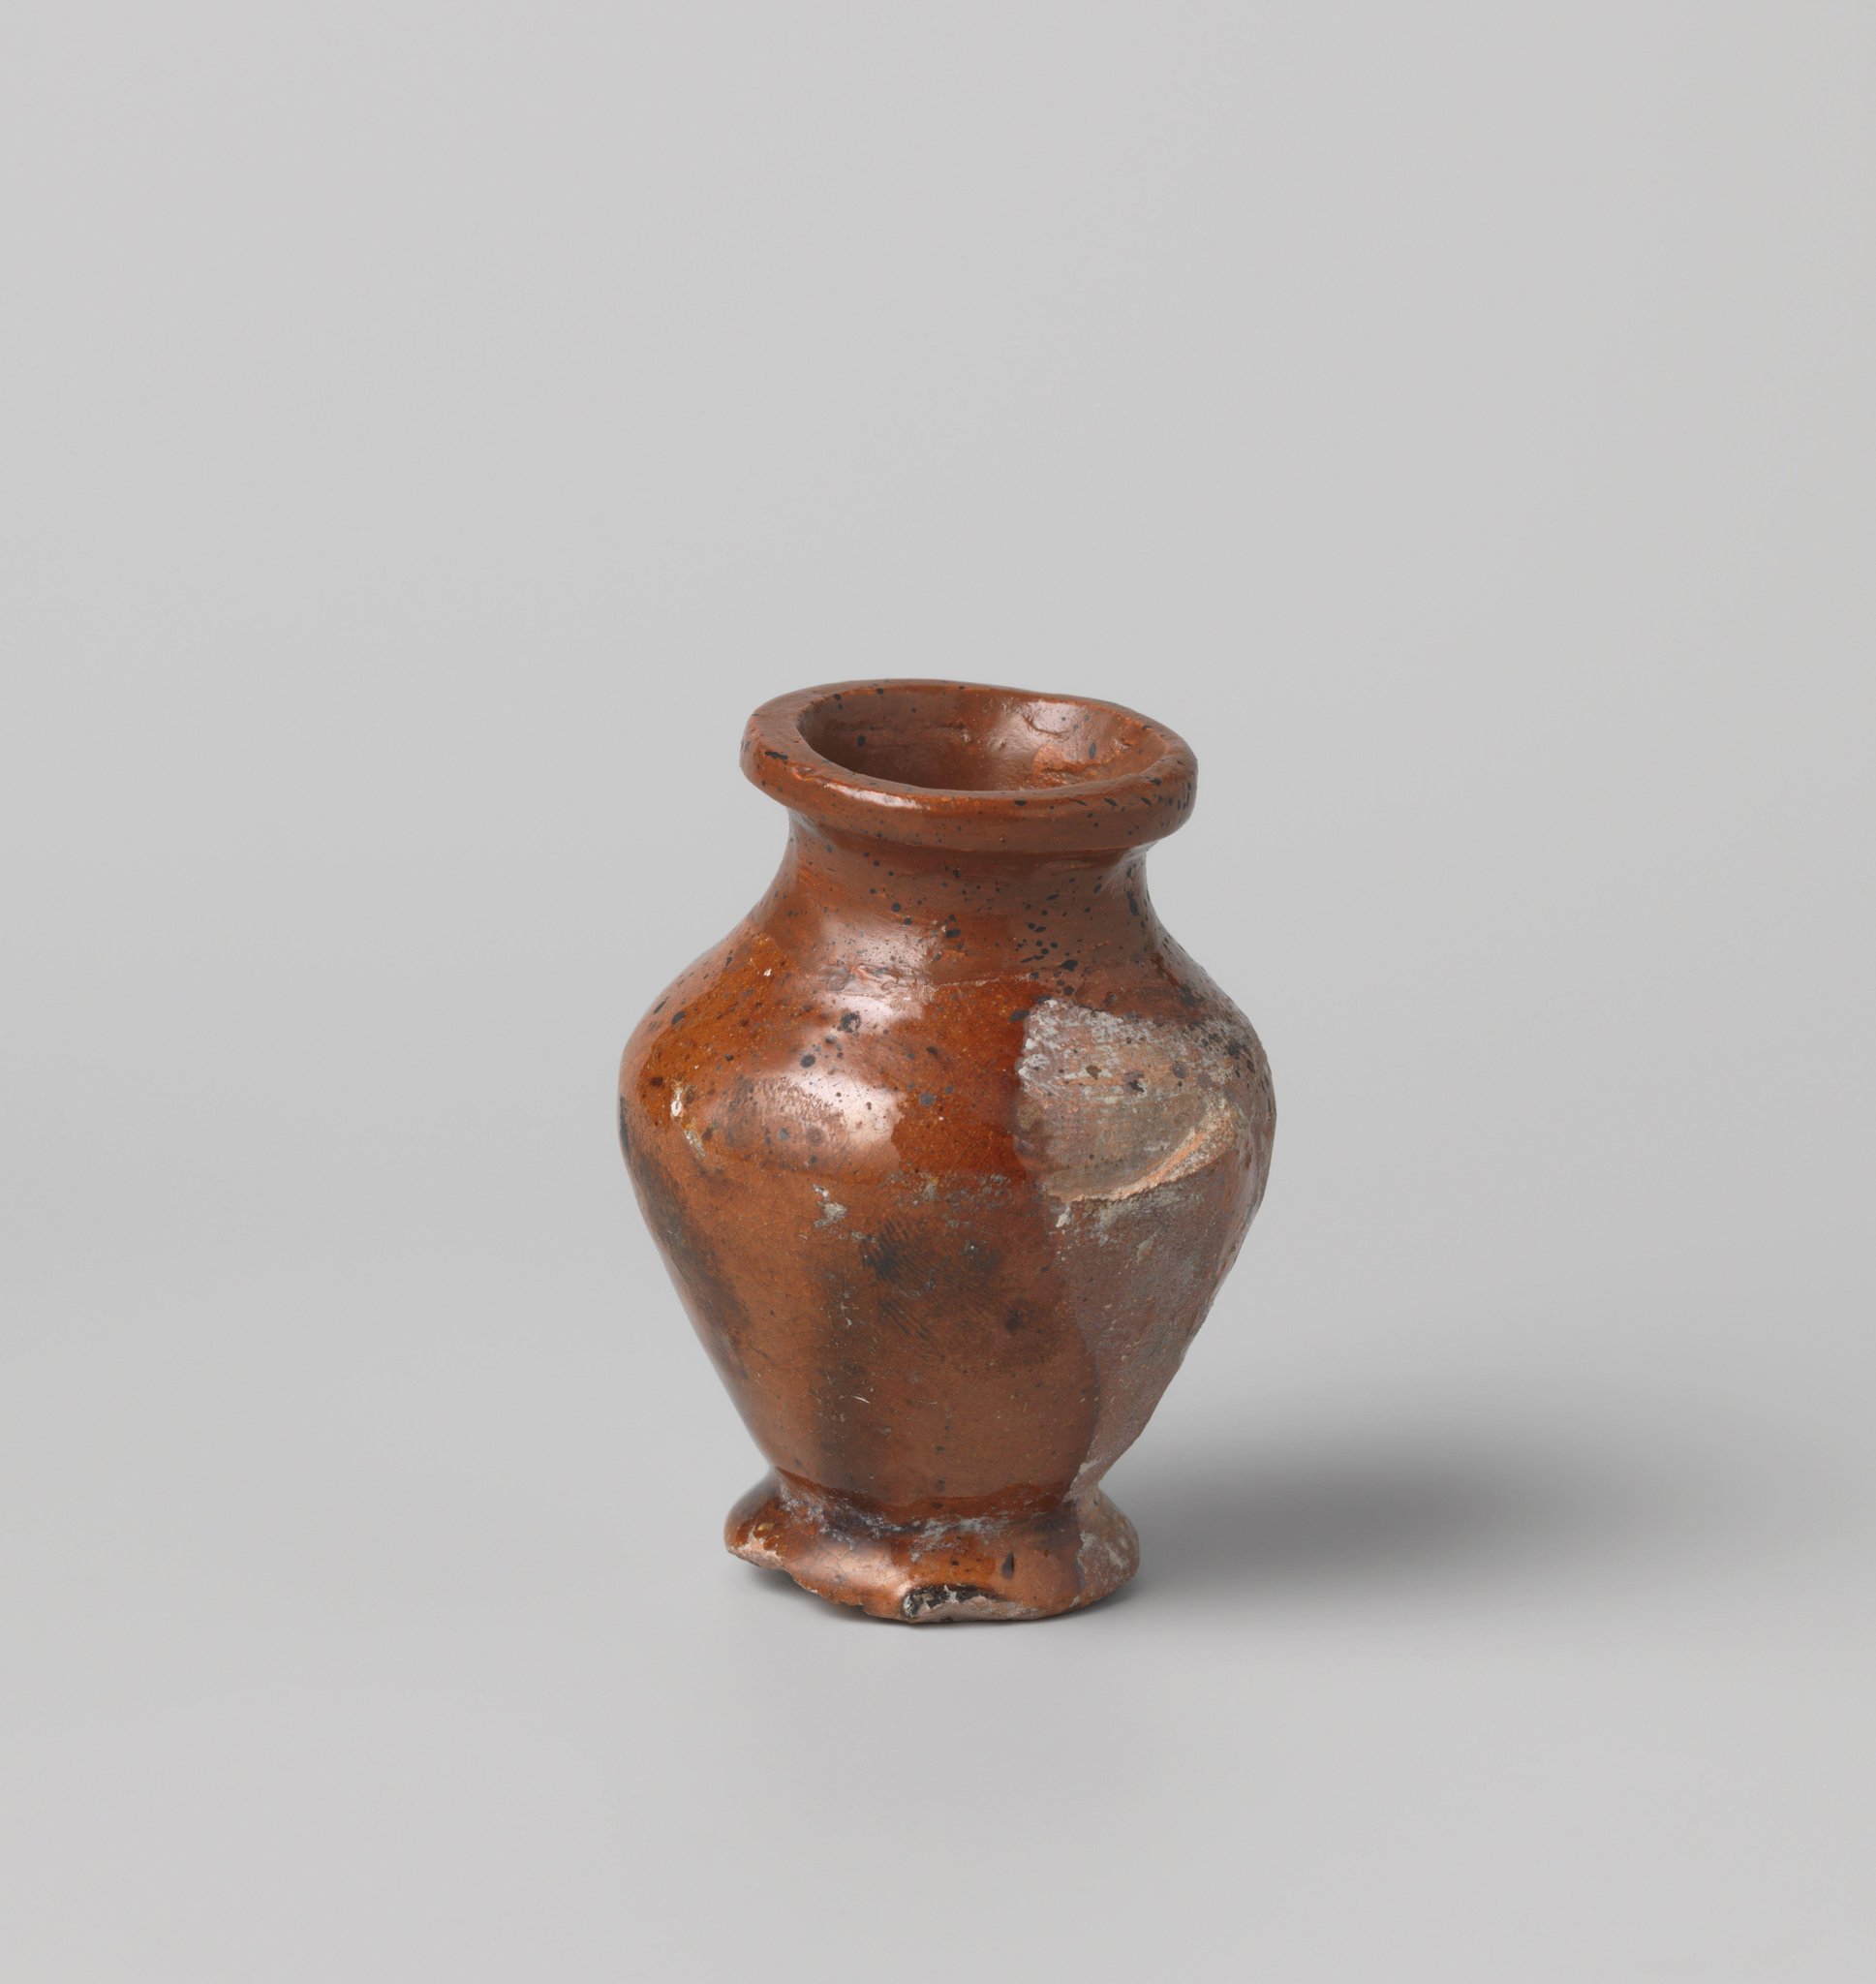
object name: pot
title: Potje of kruikje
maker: Anonymous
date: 1400-1600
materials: earthenware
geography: netherlands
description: Potje of kruikje van roodbakkend aardewerk, gedeeltelijk bruin geglazuurd. De lage voet loopt smal toe, met daarop het lichaam, dat halverwege op zijn breedst is. Bovenaan een smallere hals met een dikke rand.